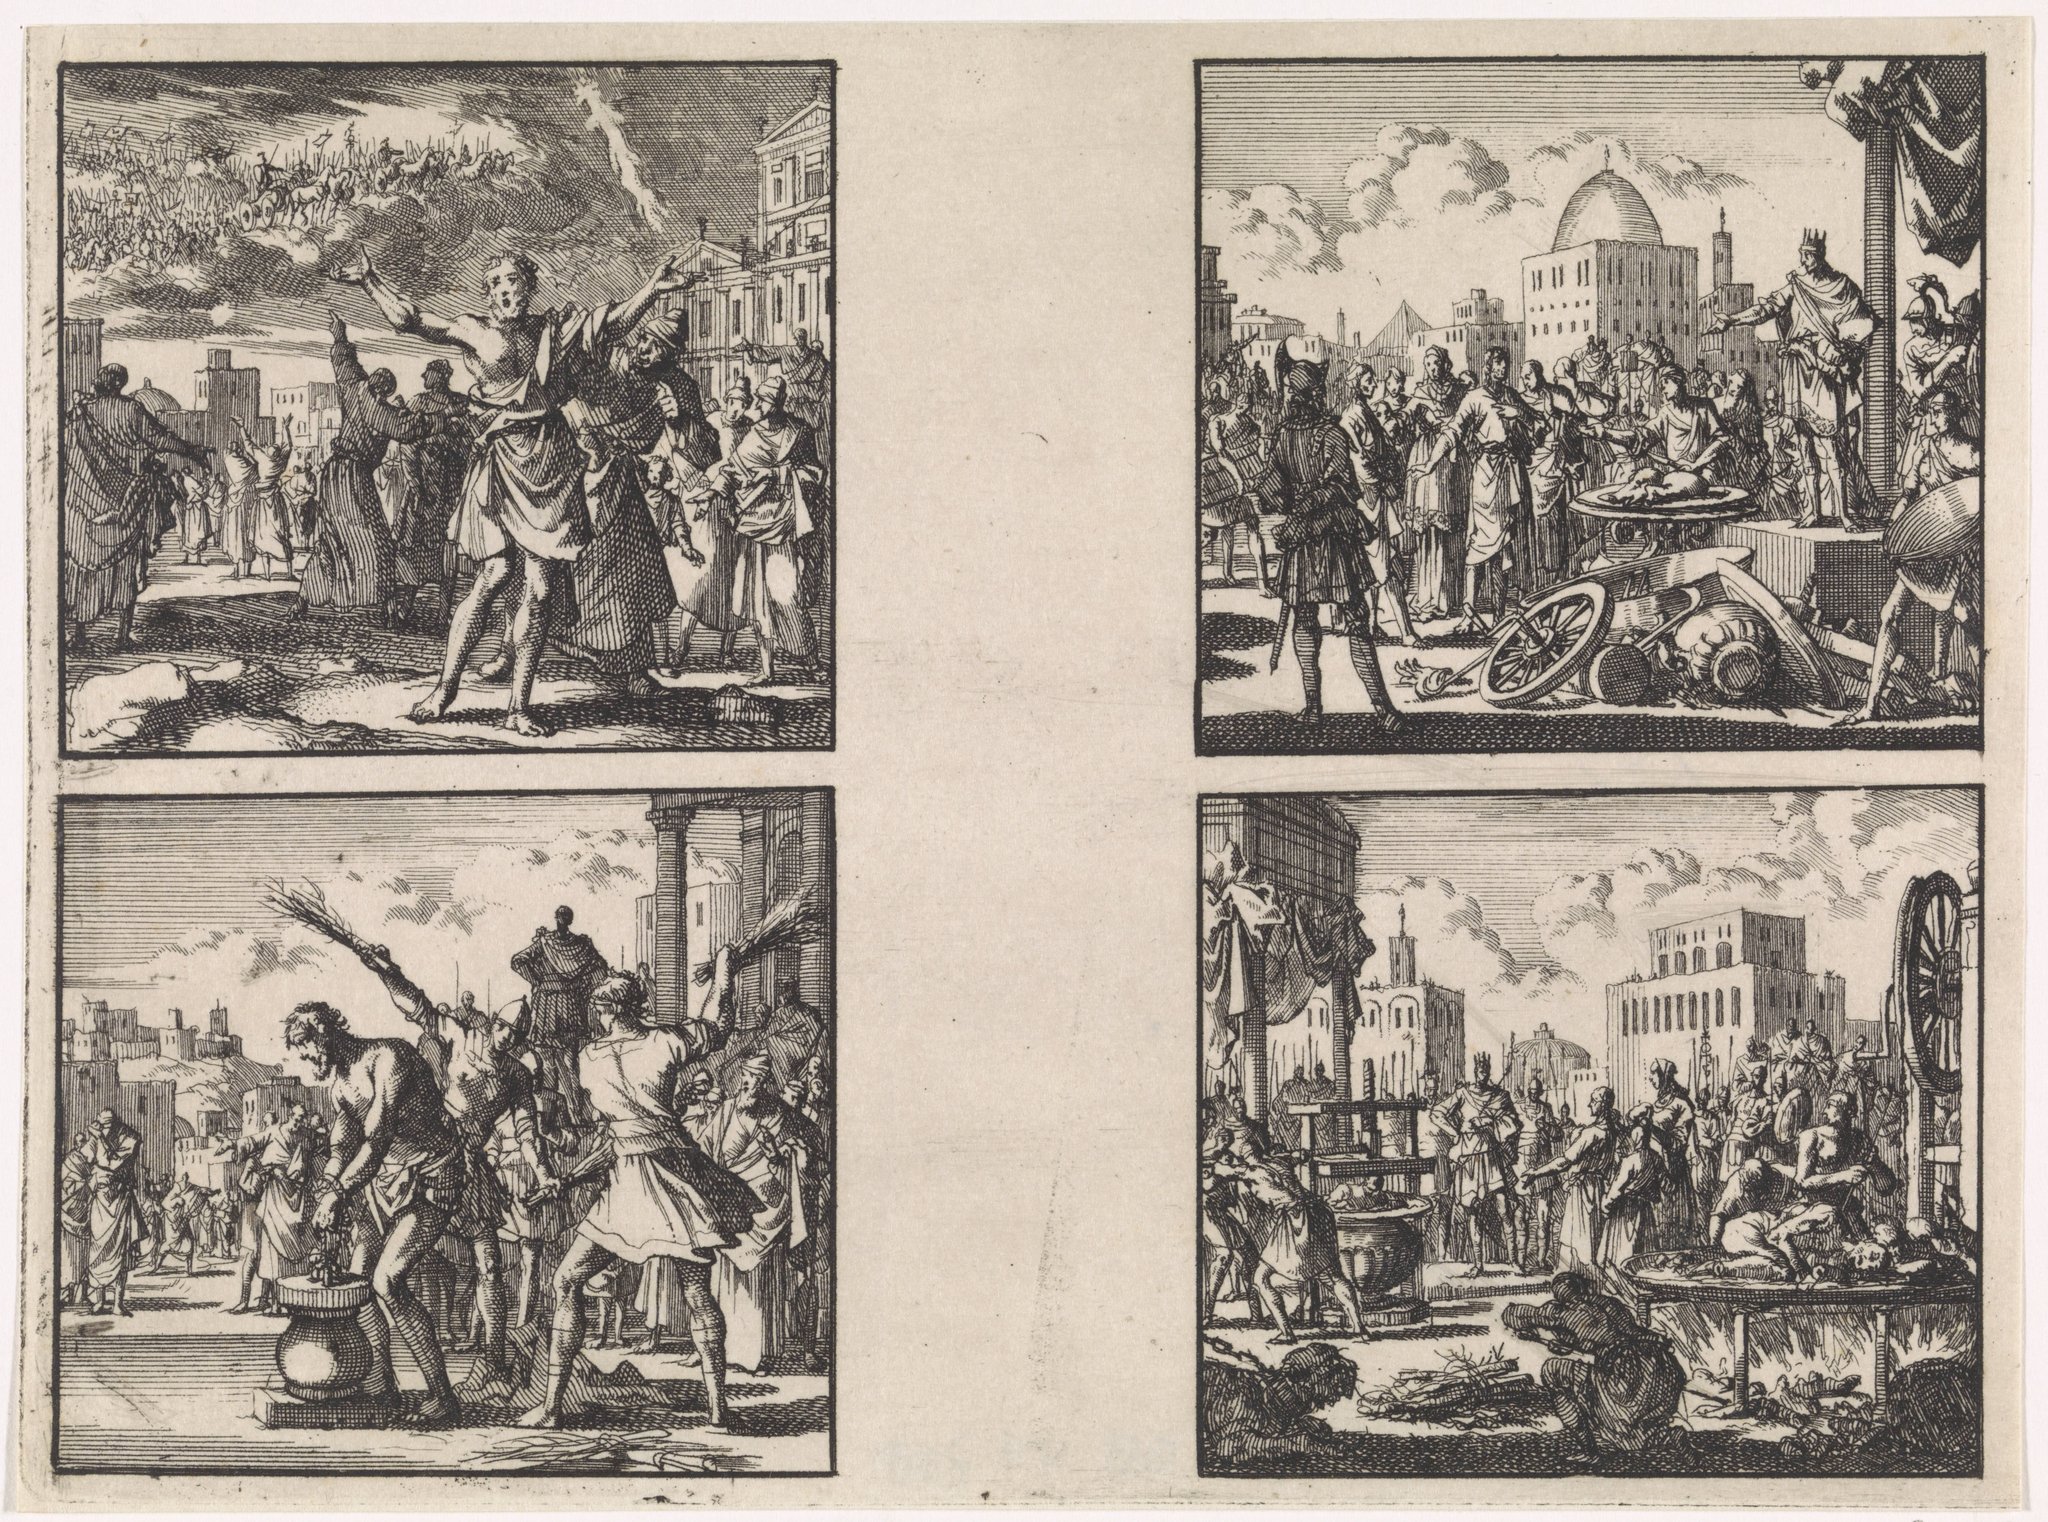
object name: print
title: Jezus ben Ananias weeklaagt over het lot van Jeruzalem / Jezus ben Ananias door de Romeinen gegeseld / Antiochus Epiphanes probeert een moeder en zeven zonen over te halen om zwijnenvlees te eten / Dood van zeven zonen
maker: jan luyken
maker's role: draughtsman, print maker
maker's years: 1649-1712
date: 1698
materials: paper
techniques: etching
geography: amsterdam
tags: flogging, scourging (in public), the martyrdom of the seven maccabean brothers and their mother under antiochus iv epiphanes (2 maccabees 7)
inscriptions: collector's mark: Lugt 2228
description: Proefdruk van illustraties uit: Josephus, Flavius. XX. boeken van de oude geschiedenissen der joden, 4 delen. Amsterdam: Barent Visscher, Willem de Coup, Willem van Lamsveld, Andries van Damme, 1698, dl. III.